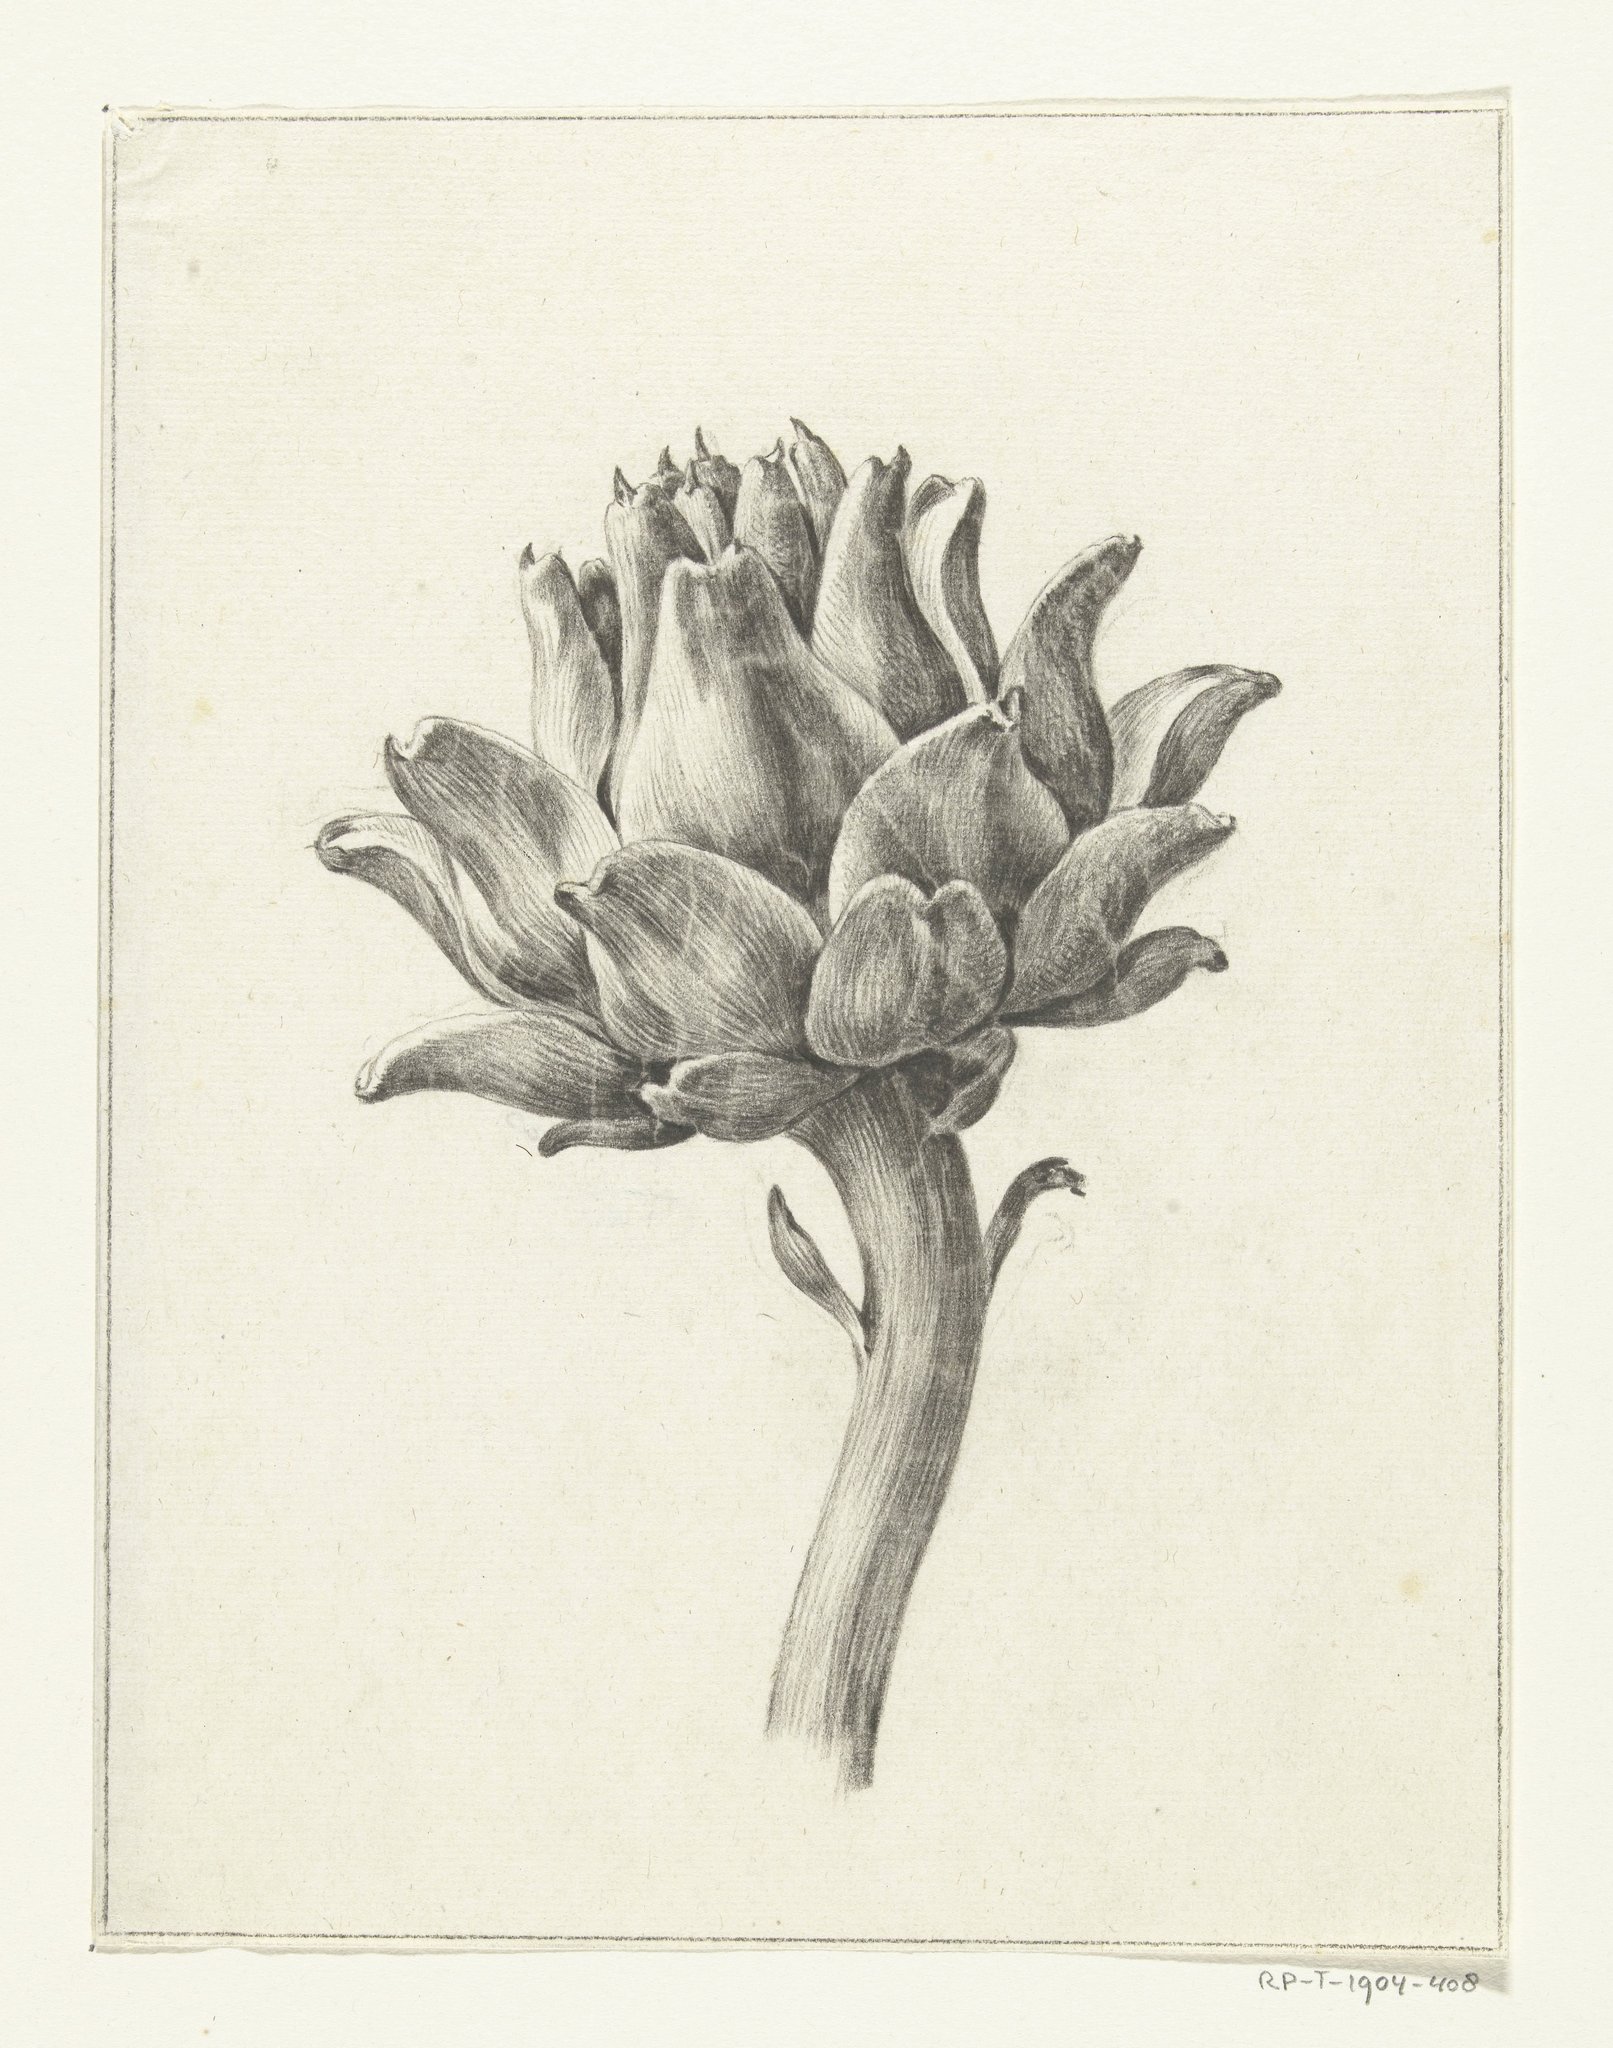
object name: drawing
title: Artisjok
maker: jean bernard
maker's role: draughtsman, print maker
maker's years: 1765-1833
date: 1775-1833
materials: chalk, paper, pencil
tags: plants and herbs: artichoke